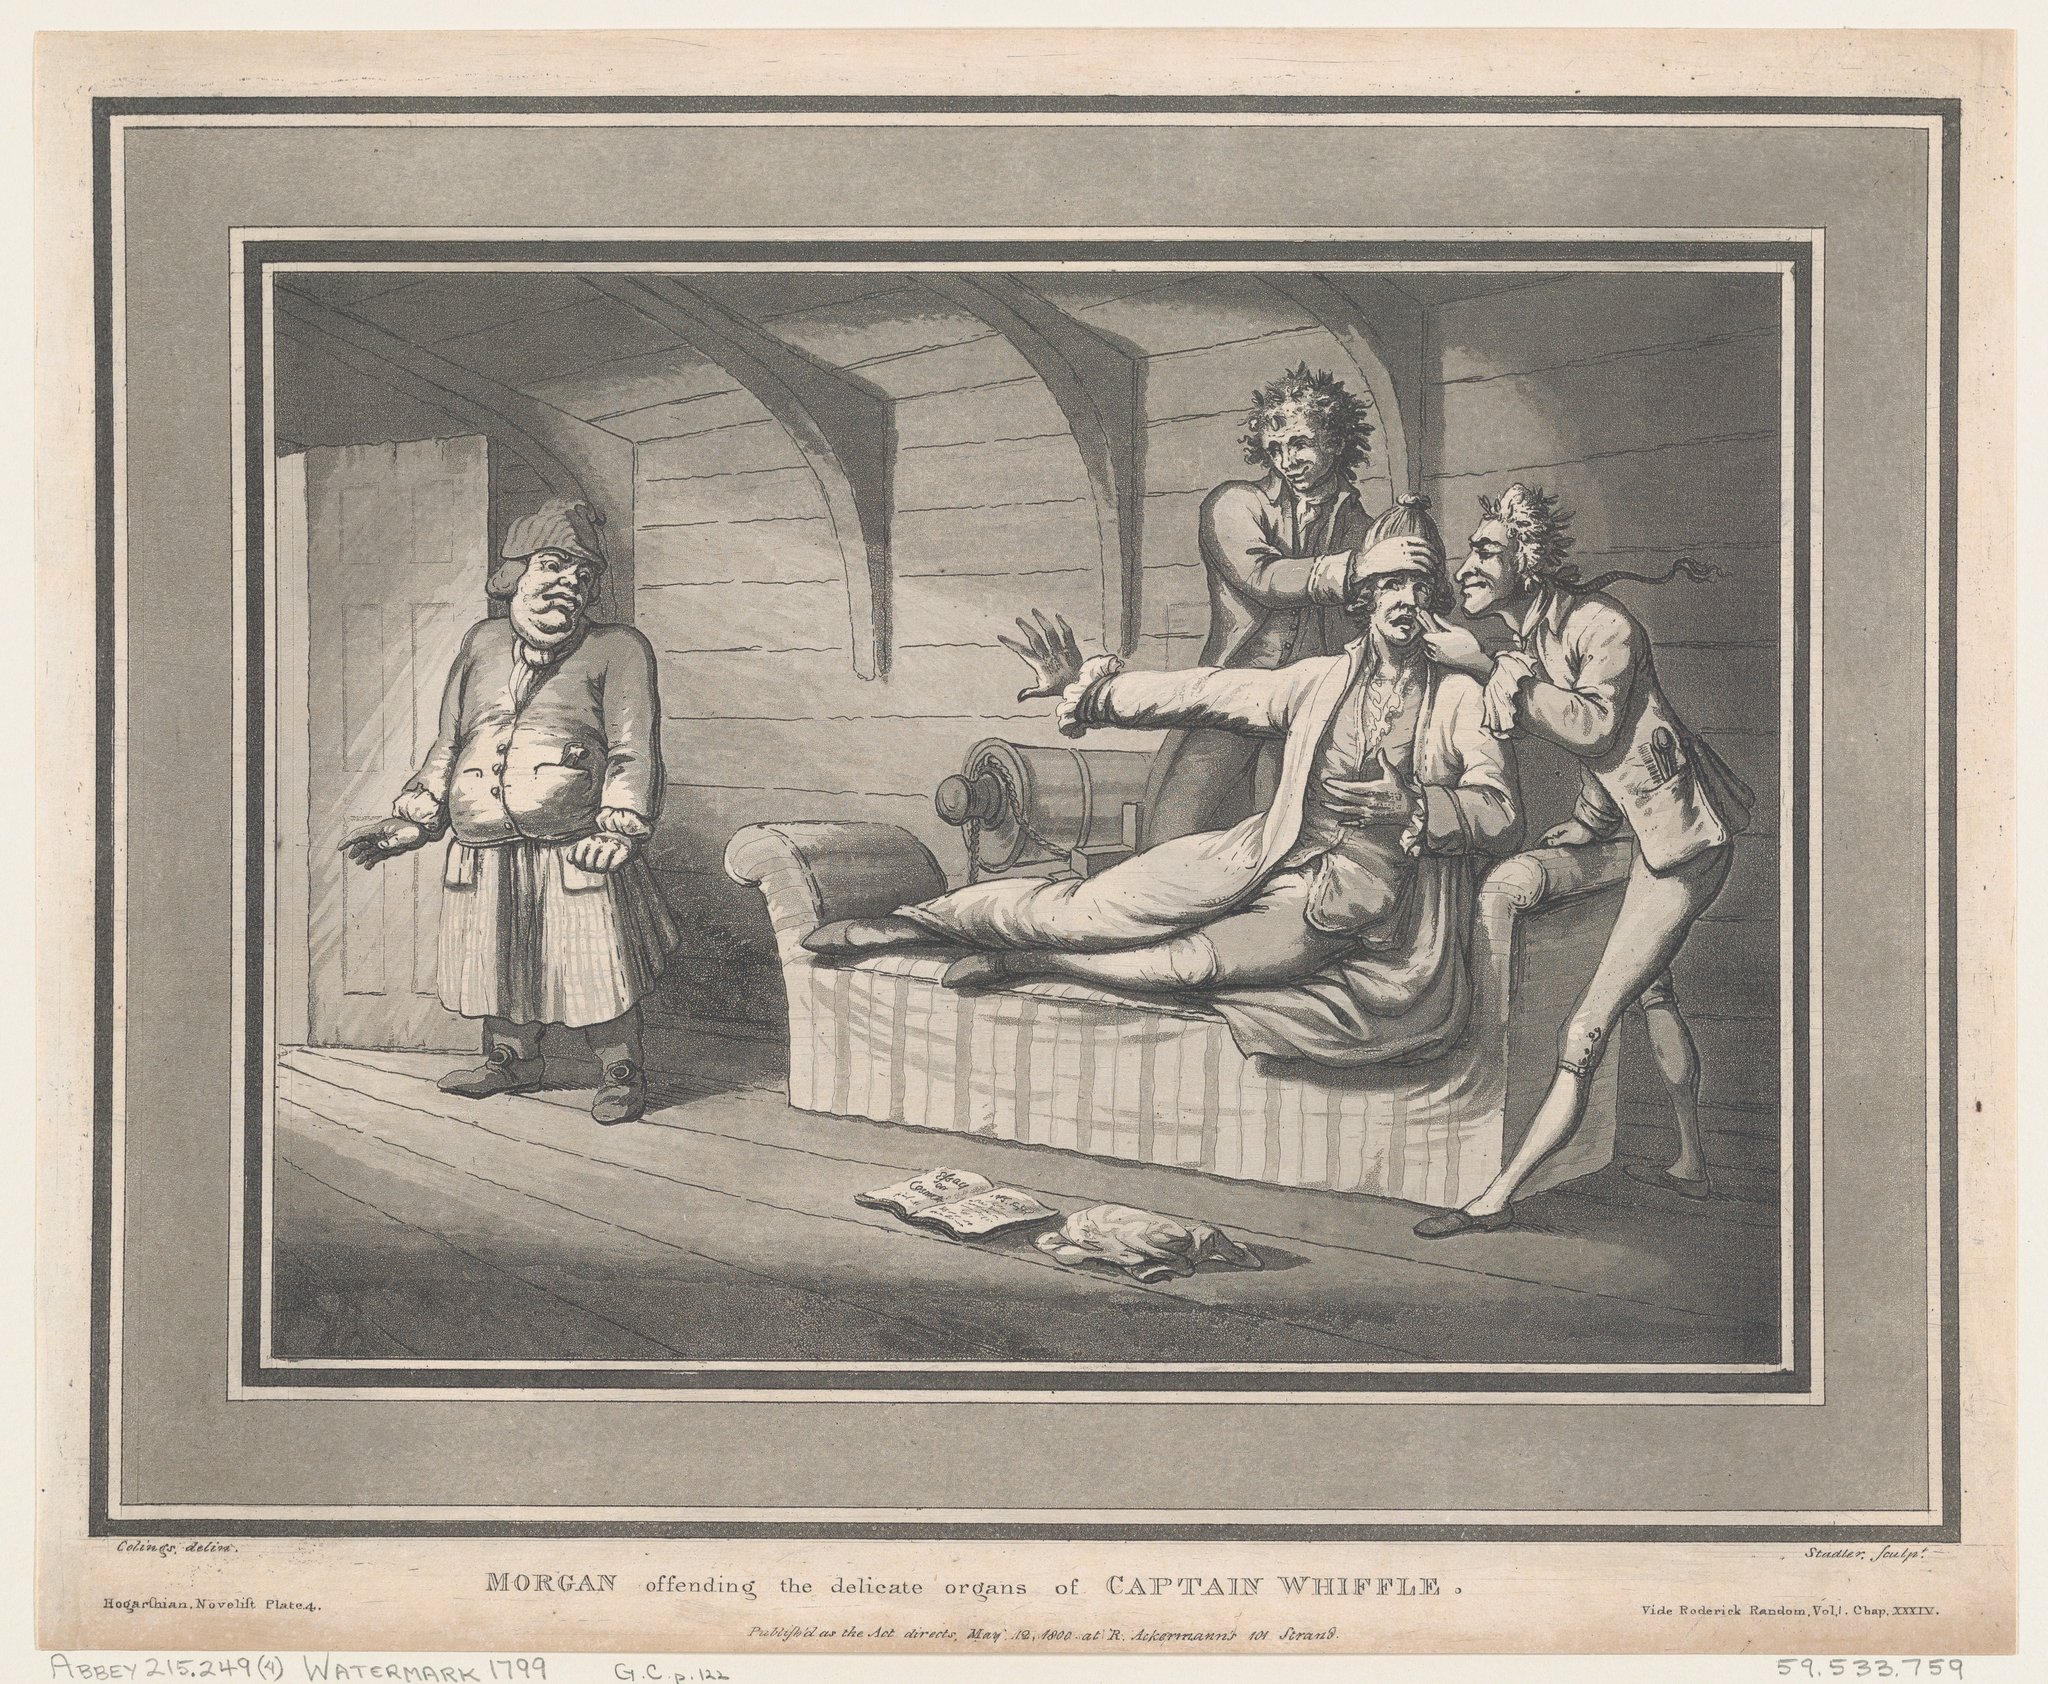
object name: print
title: Morgan Offending The Delicate Organs of Captain Whiffle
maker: thomas rowlandson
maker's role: artist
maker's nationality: british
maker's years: 1757-1827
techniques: aquatint, etching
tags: men